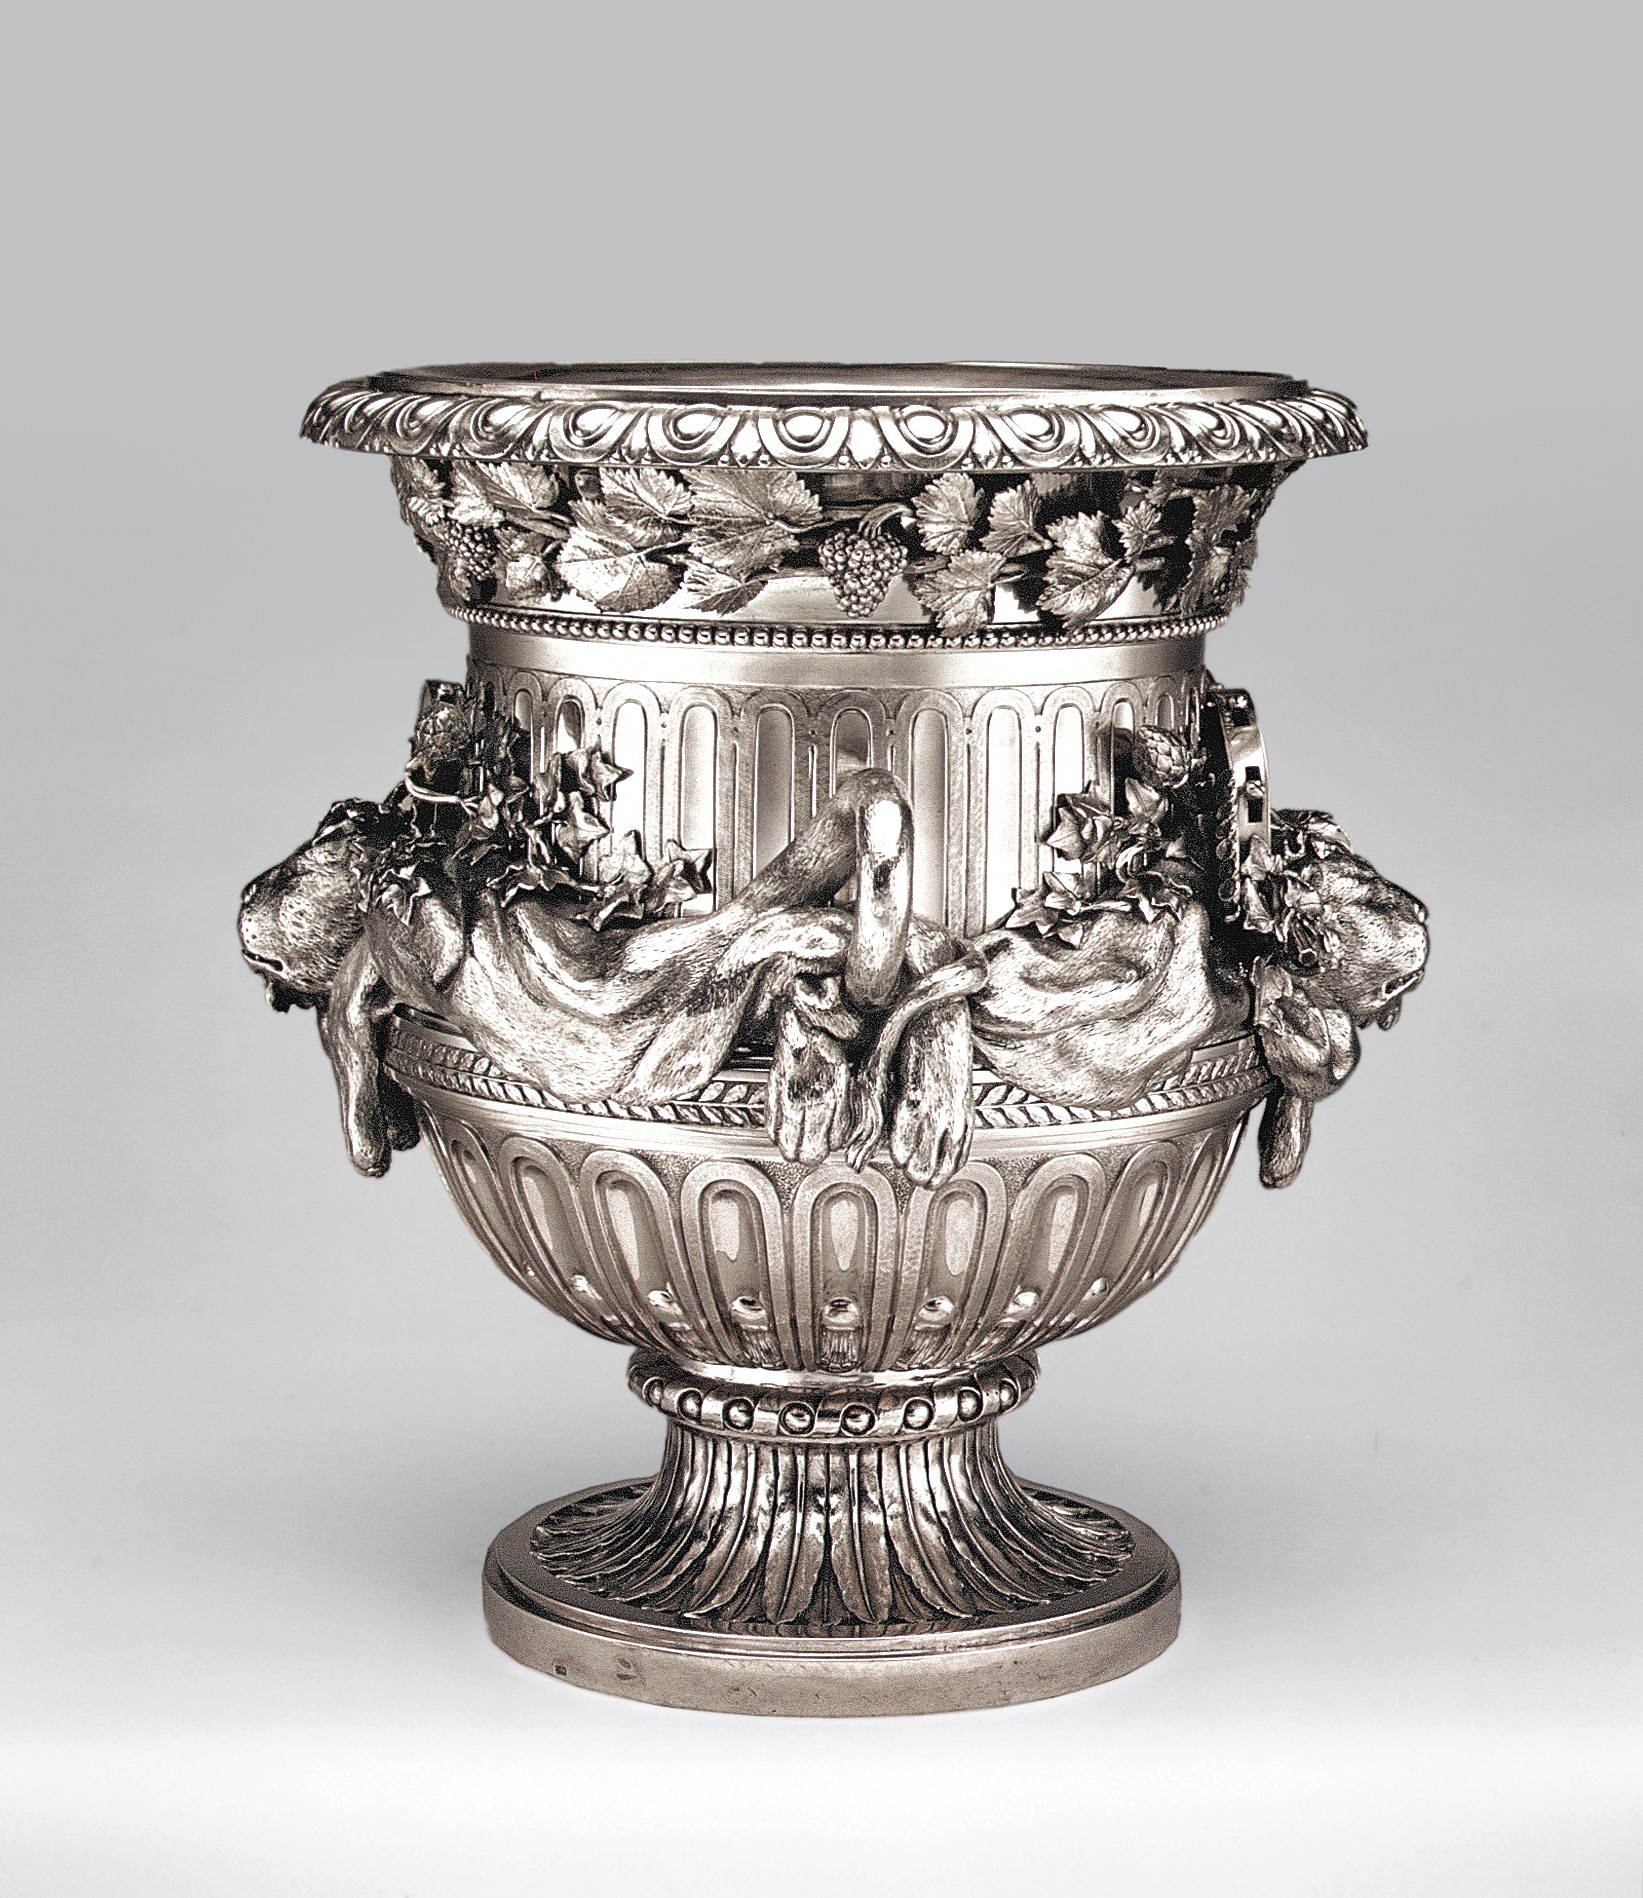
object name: wine cooler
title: Wine cooler (one of a pair)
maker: ignaz joseph würth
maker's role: maker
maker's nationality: austrian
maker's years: 1692-1792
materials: silver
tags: lions